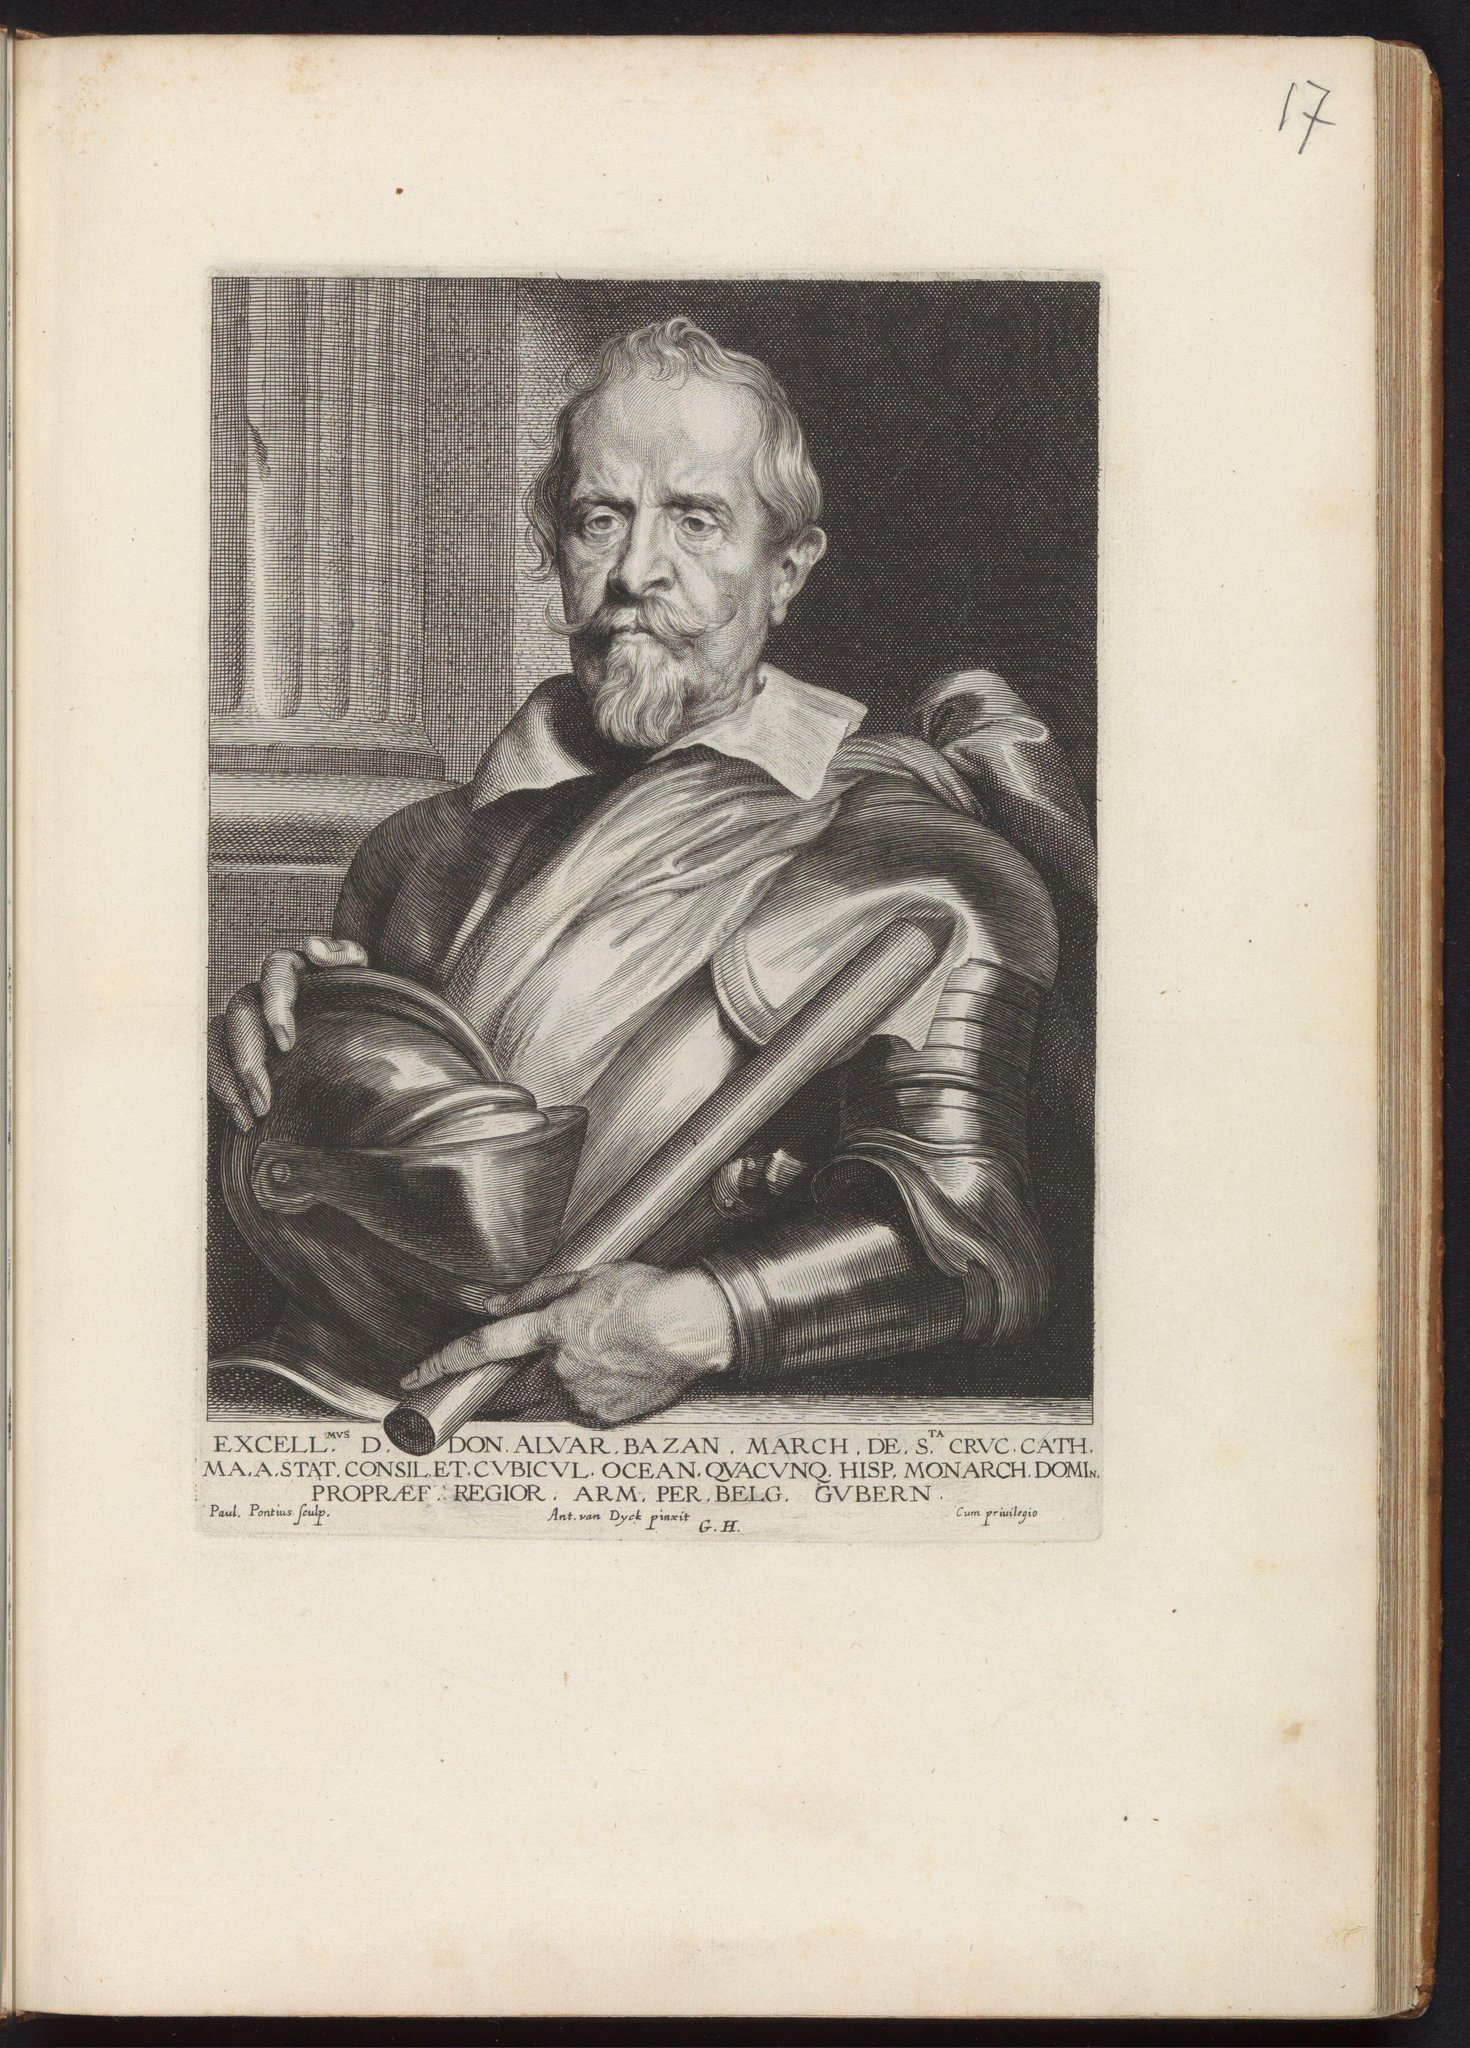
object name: print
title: Iconographie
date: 1630-1641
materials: paper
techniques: engraving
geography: antwerp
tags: álvaro de bazán, armour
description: Deze prent maakt deel uit van een album.